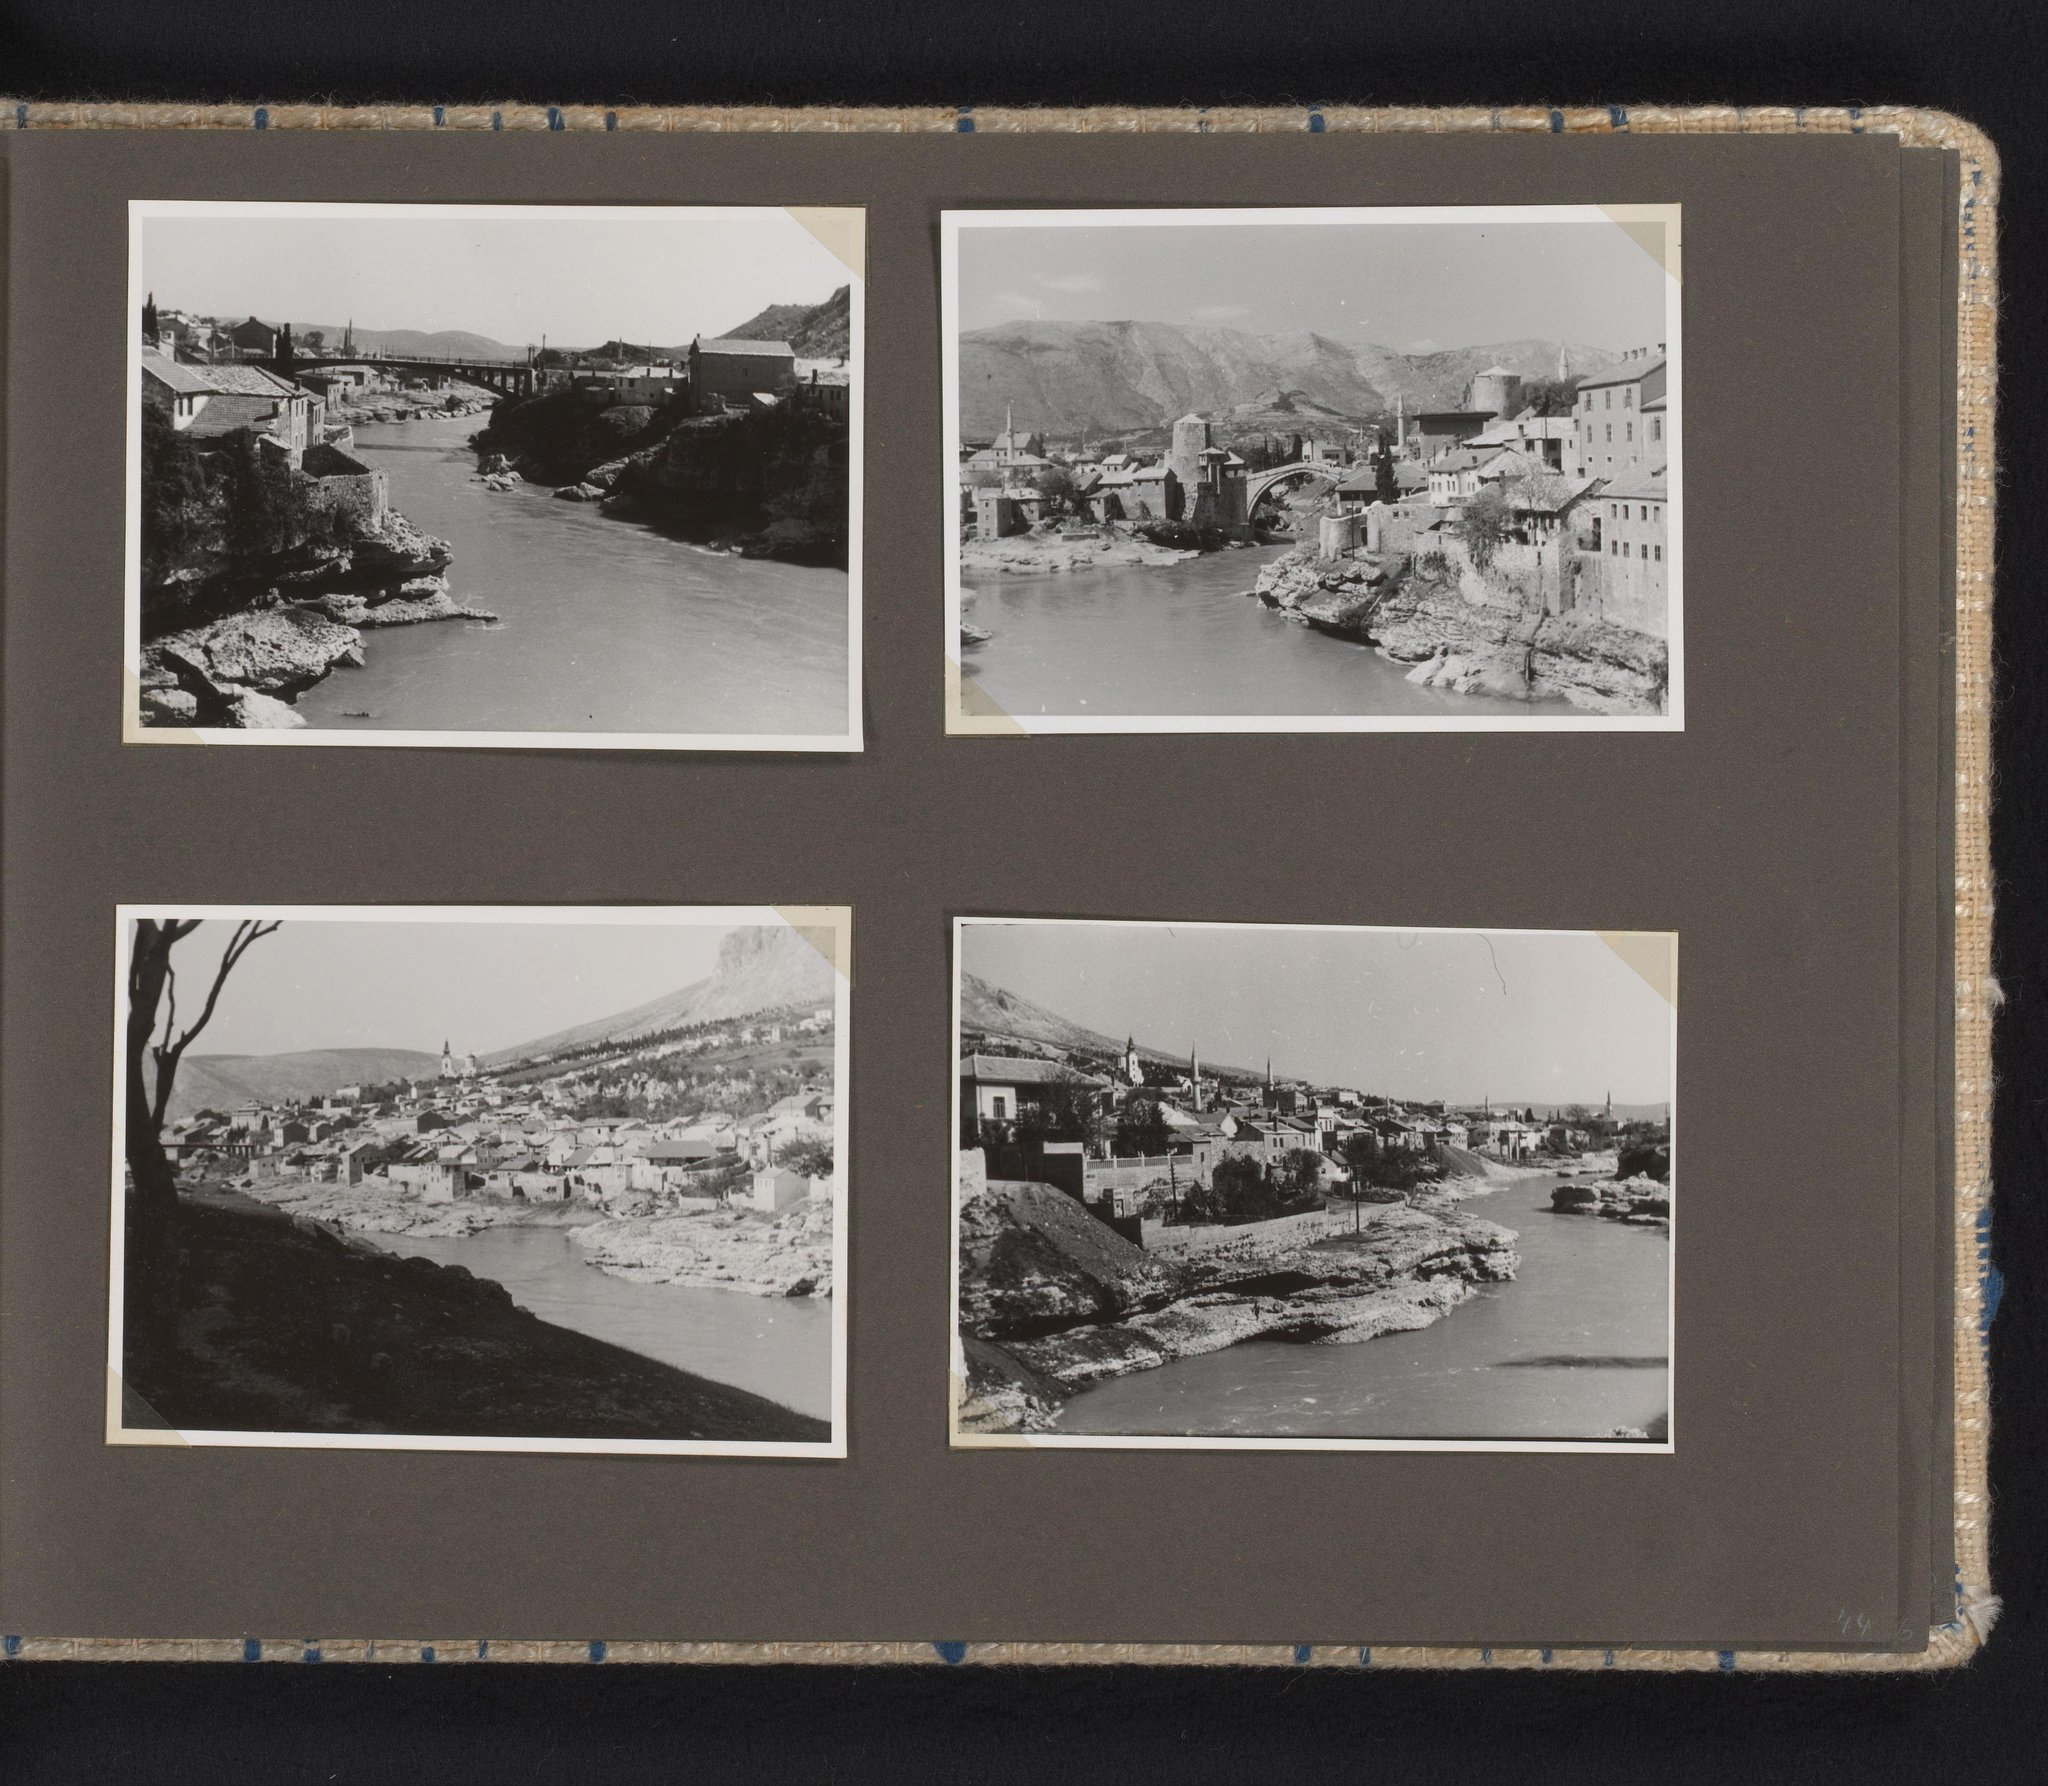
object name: album leaf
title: Mostar in Joegoslavië, april 1943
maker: Anonymous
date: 1904-1943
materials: cardboard, photographic support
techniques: gelatin silver print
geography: mostar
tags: city-view in general; 'veduta', temple, shrine ~ islam, mohammedanism, bridge in city across river, canal, etc., occupation ~ war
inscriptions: inscription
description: Albumblad met vier foto's gemaakt in Mostar in Joegoslavië, april 1943: gezichten in de stad met de brug Stari Most. Onderdeel van het fotoalbum Abrechnungsintendantur van de Wehrmacht 1941-1943.